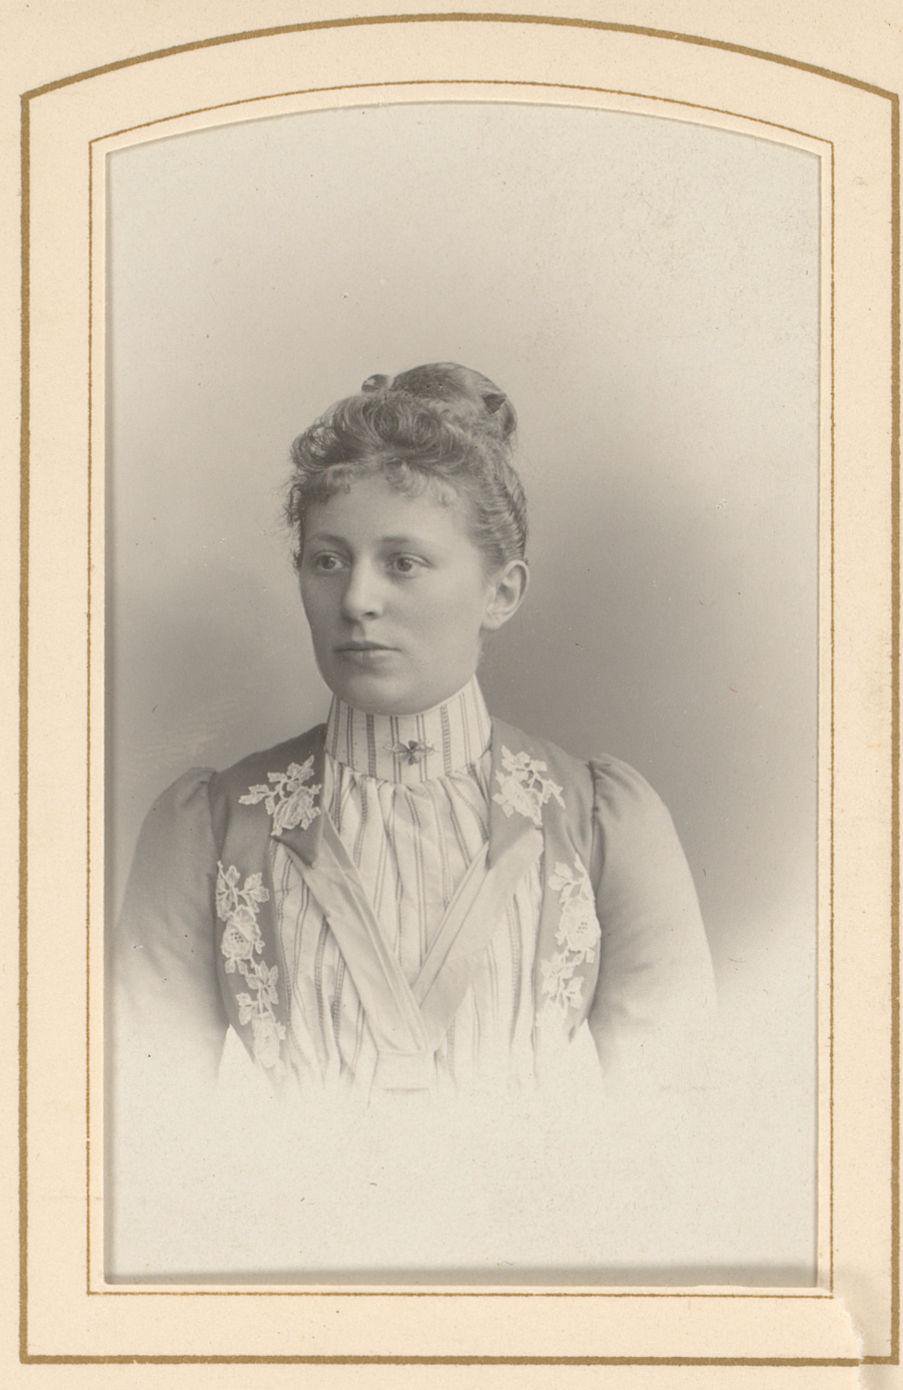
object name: photograph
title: Portret van een vrouw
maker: theodor penz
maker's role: fotograaf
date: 1895-1920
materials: cardboard, photographic support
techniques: matte daylight collodion silver print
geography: charlottenburg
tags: historical persons - bb - woman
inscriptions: name: ‘Hedweig Sch[ät]ze/ frau von Carl’, inscription: ‘Atelier für Photographie/ Vergrösserungs-Anstalt/ FERNSPRECHER/ AMT CHARLOTTENBURG/ No 804./ Theodor Penz/ Charlottenburg Kant-Str. 156/ 157/ gegenüber dem Theater des Westens/ nahe Bahnhof Zoologischer Garten./ Die Platte bleibt zu Nachbestellungen aufbewahrt.’